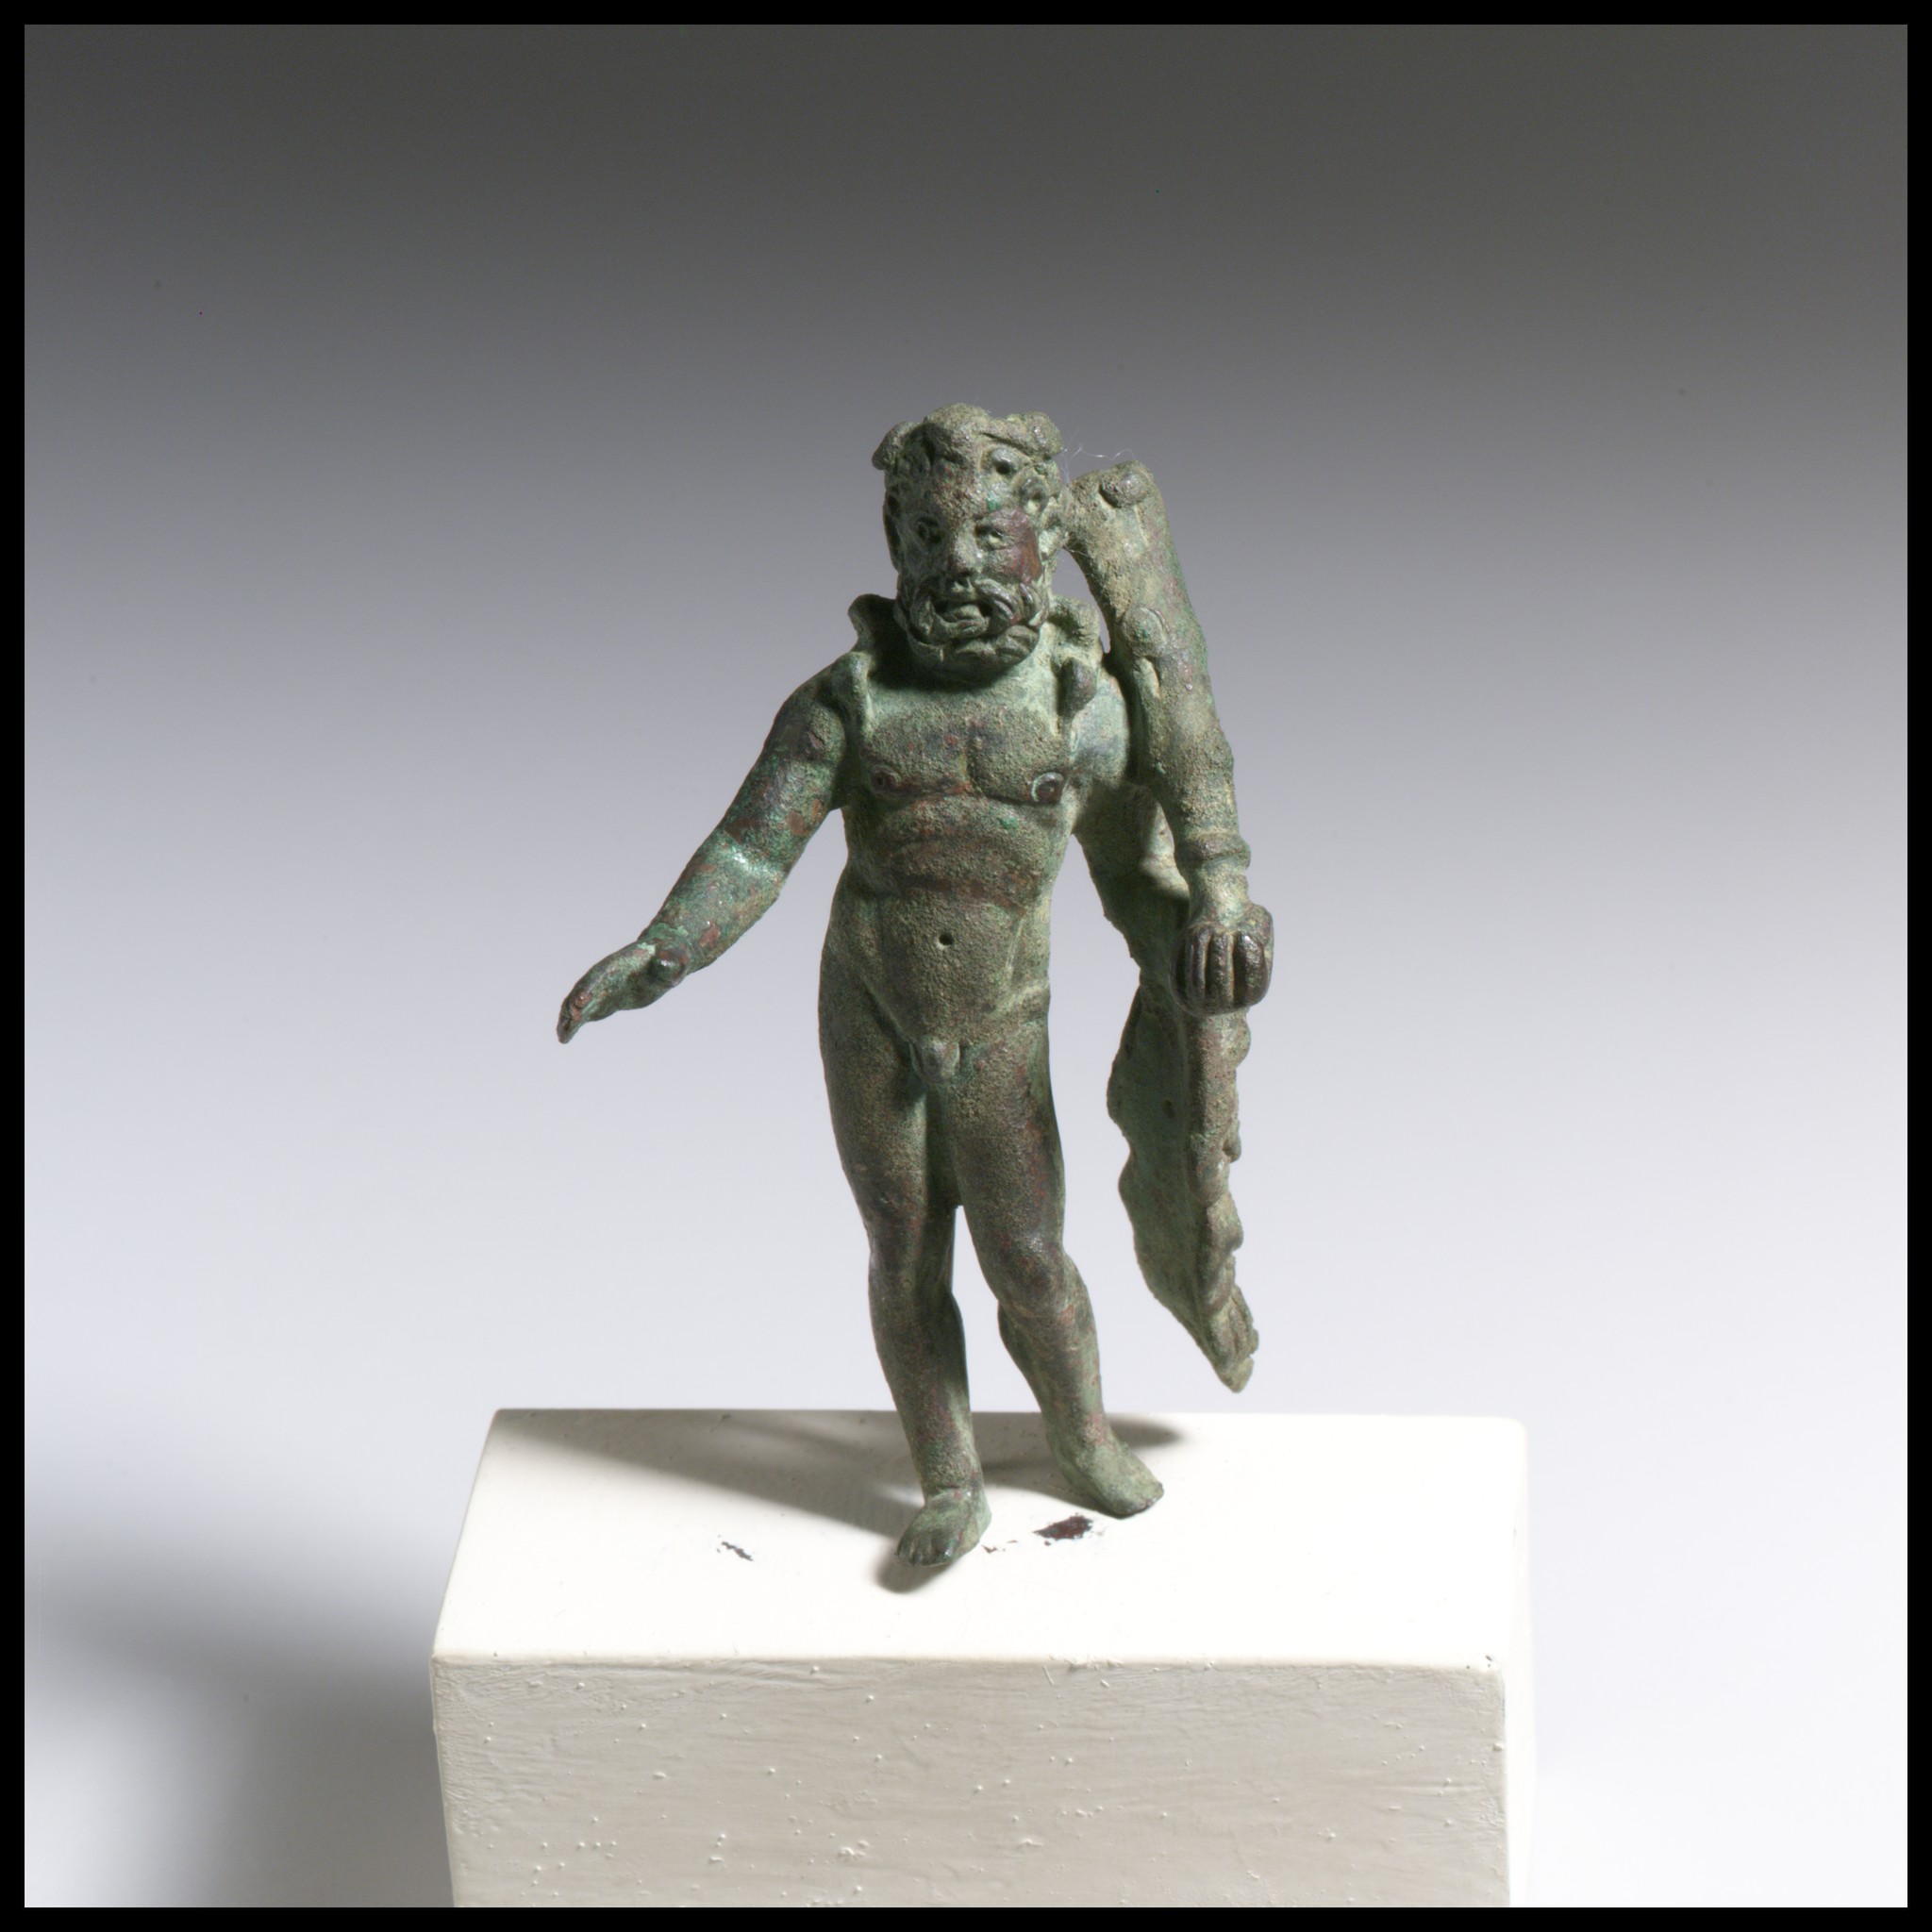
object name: statuette of herakles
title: Bronze statuette of Hercules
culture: roman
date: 1-200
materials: bronze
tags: male nudes,herakles